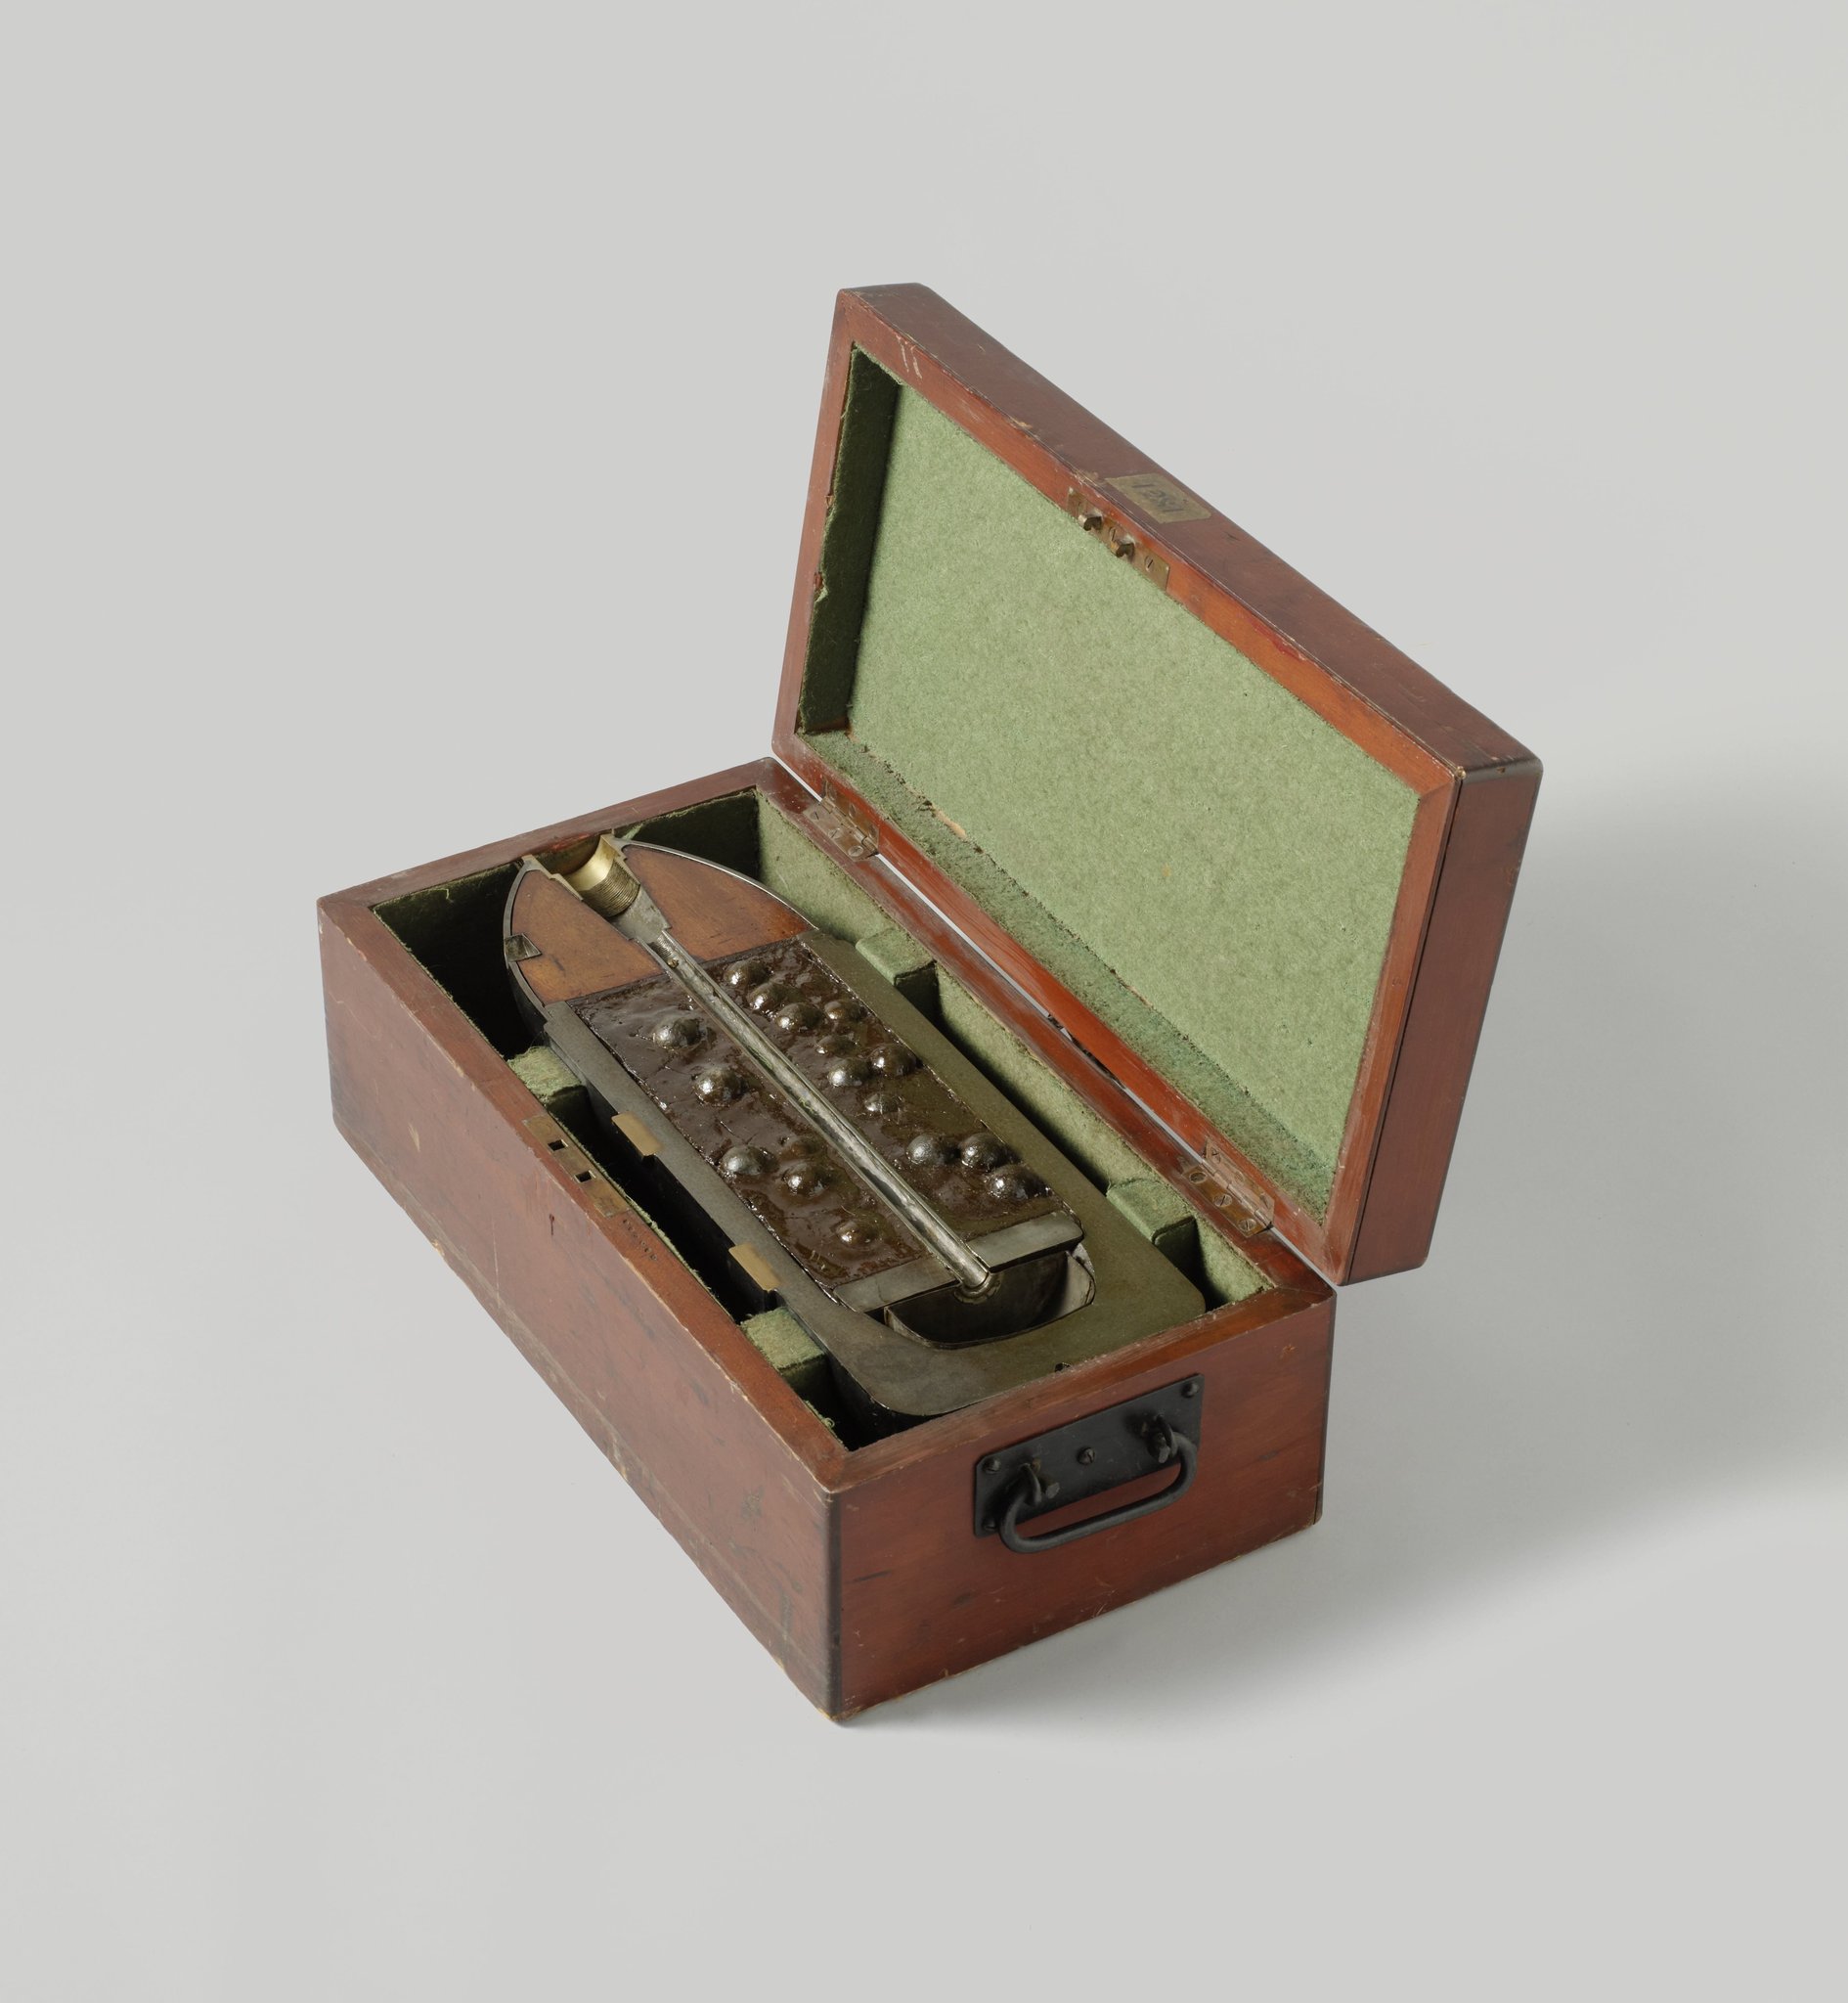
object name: grenade ammunition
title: 18-cm Shrapnel Shell in a Wooden Box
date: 1868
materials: brass, bronze, iron, lead, wood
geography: newcastle upon tyne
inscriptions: inscription, on the lock of the box: ‘John Shaw & Sons / Wolverhampton / Safety patent lever lock.’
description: This shrapnel shell has been sawn down the middle, showing how deadly it was, for there are balls of lead shot, with a diameter of 24 mm, packed above the explo-sive charge. These shells were produced by the British firm of Armstrong from 1868. Although the Royal Nether-lands Navy certainly used 18 cm calibre artillery made by Armstrong, it is not known whether the navy also used this type of shrapnel, which is of the same calibre.